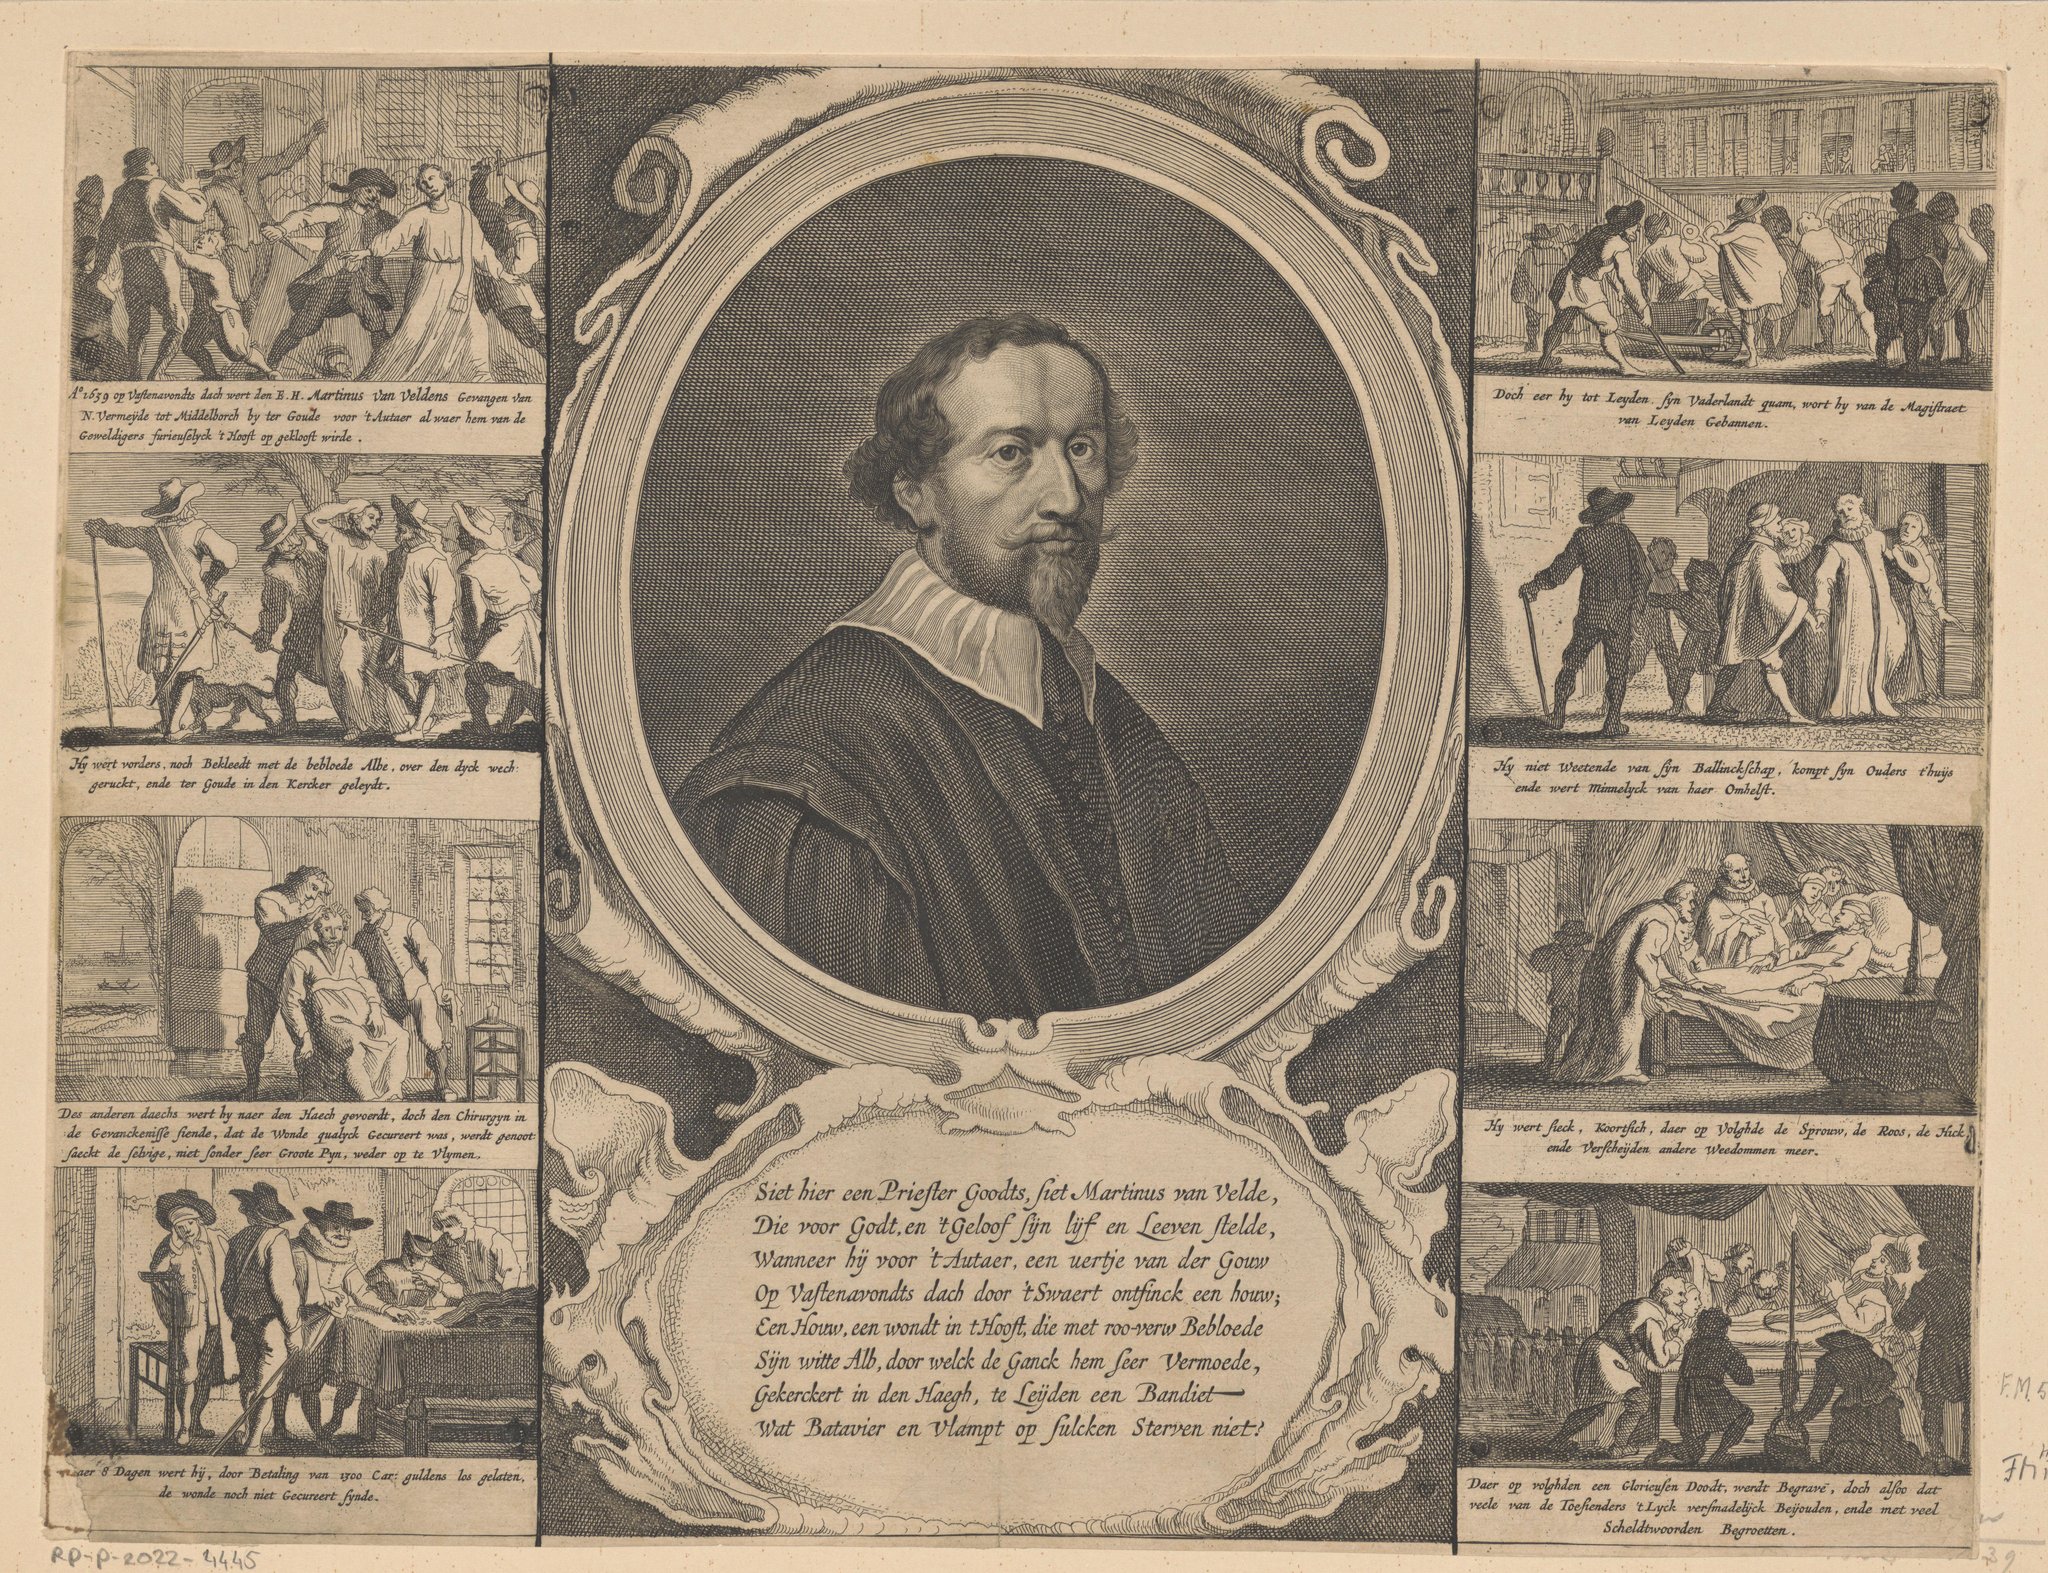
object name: print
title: Portret van Martinus van Velden omringd door scènes uit zijn leven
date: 1639-1676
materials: paper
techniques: engraving, etching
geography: northern netherlands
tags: leiden, priest, priest (roman catholic), historical persons, martyr(s) (often with palm-branches), violent death, being killed; being mishandled and maltreated; seeking death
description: Onder het portret een achtregelig vers in het Nederlands. Aan weerszijden in acht kleine scènes zijn martelaarschap: hoe de priester op 6 maart 1639 door Nicolaas Vermeyde mishandeld en gevangengenomen wordt te Middelburg (bij Gouda), verbannen uit Leiden en ten slotte overlijdt aan zijn verwondingen op 6 april 1639.